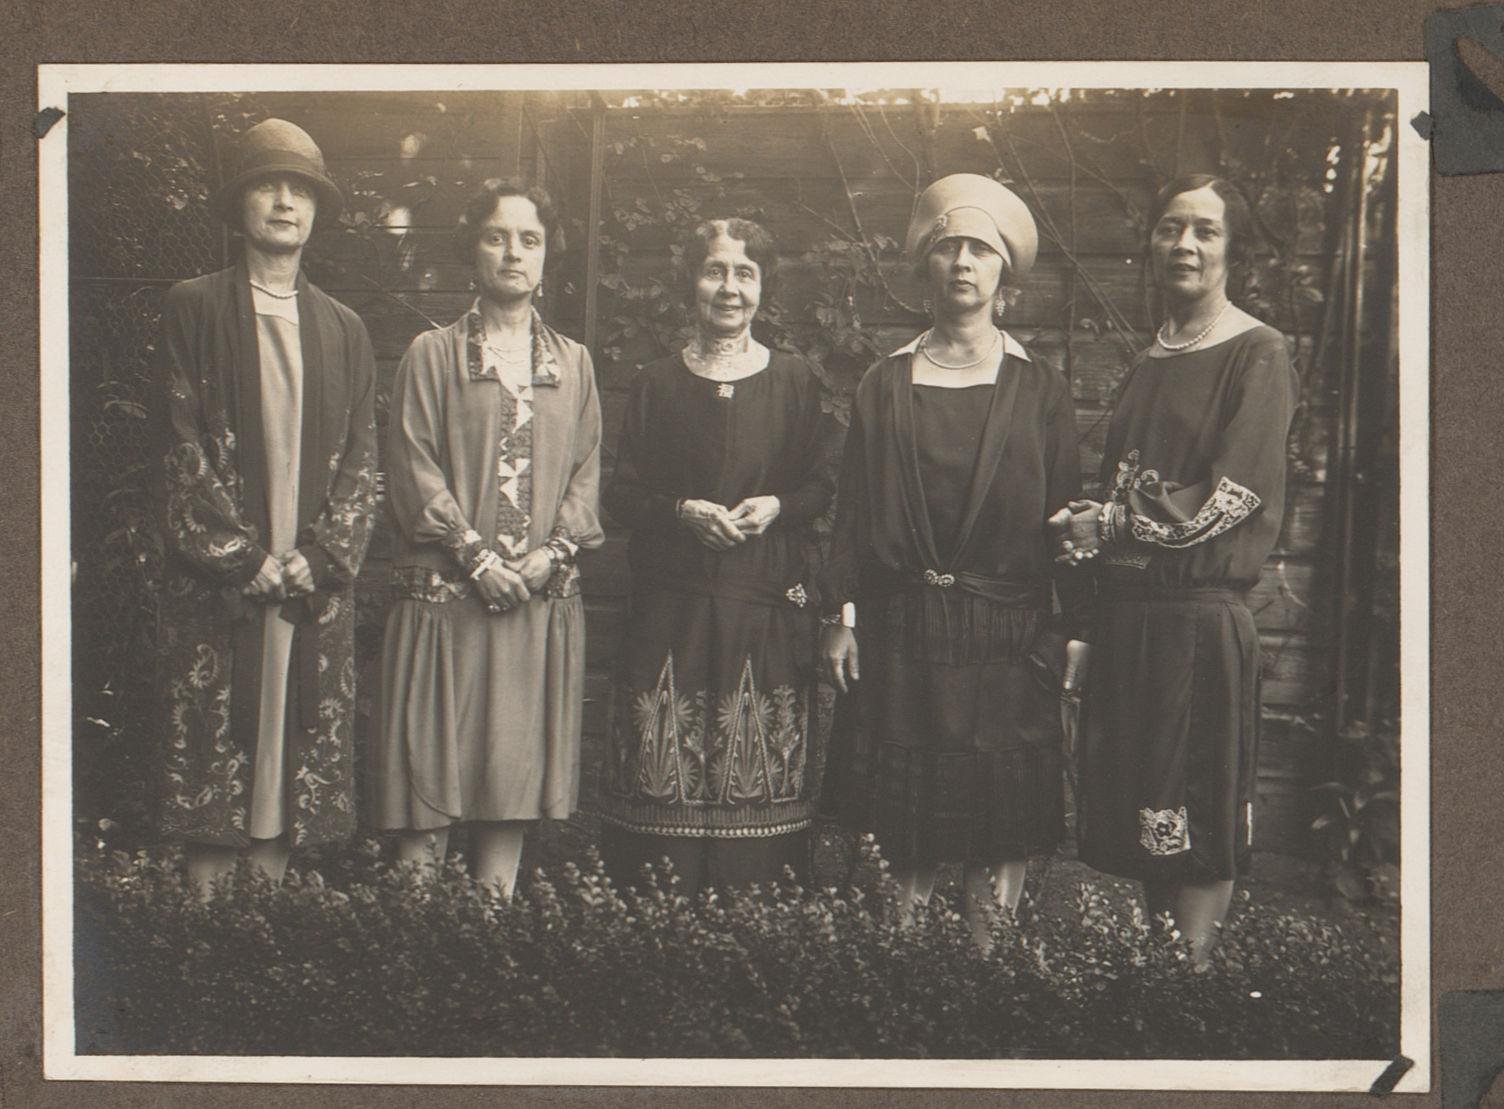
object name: album leaf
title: Groepsportret van Catherine Gertrude van Delden met haar dochters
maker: Anonymous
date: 1930-1935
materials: paper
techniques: gelatin silver print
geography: netherlands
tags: batavia, the hague, henriëtte wassink, adult woman, mother and daughter(s) (family group), netherlands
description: Van links naar rechts: Tootje Wassink, Henriëtte Wassink, Catherine Gertrude van Delden, Bertha Wassink en Milex Wassink.